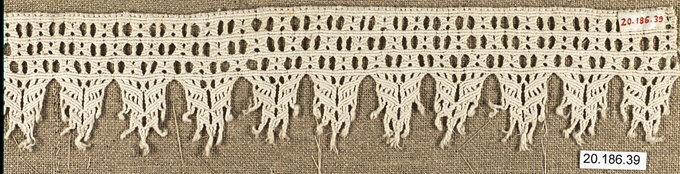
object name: edging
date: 1601-1700